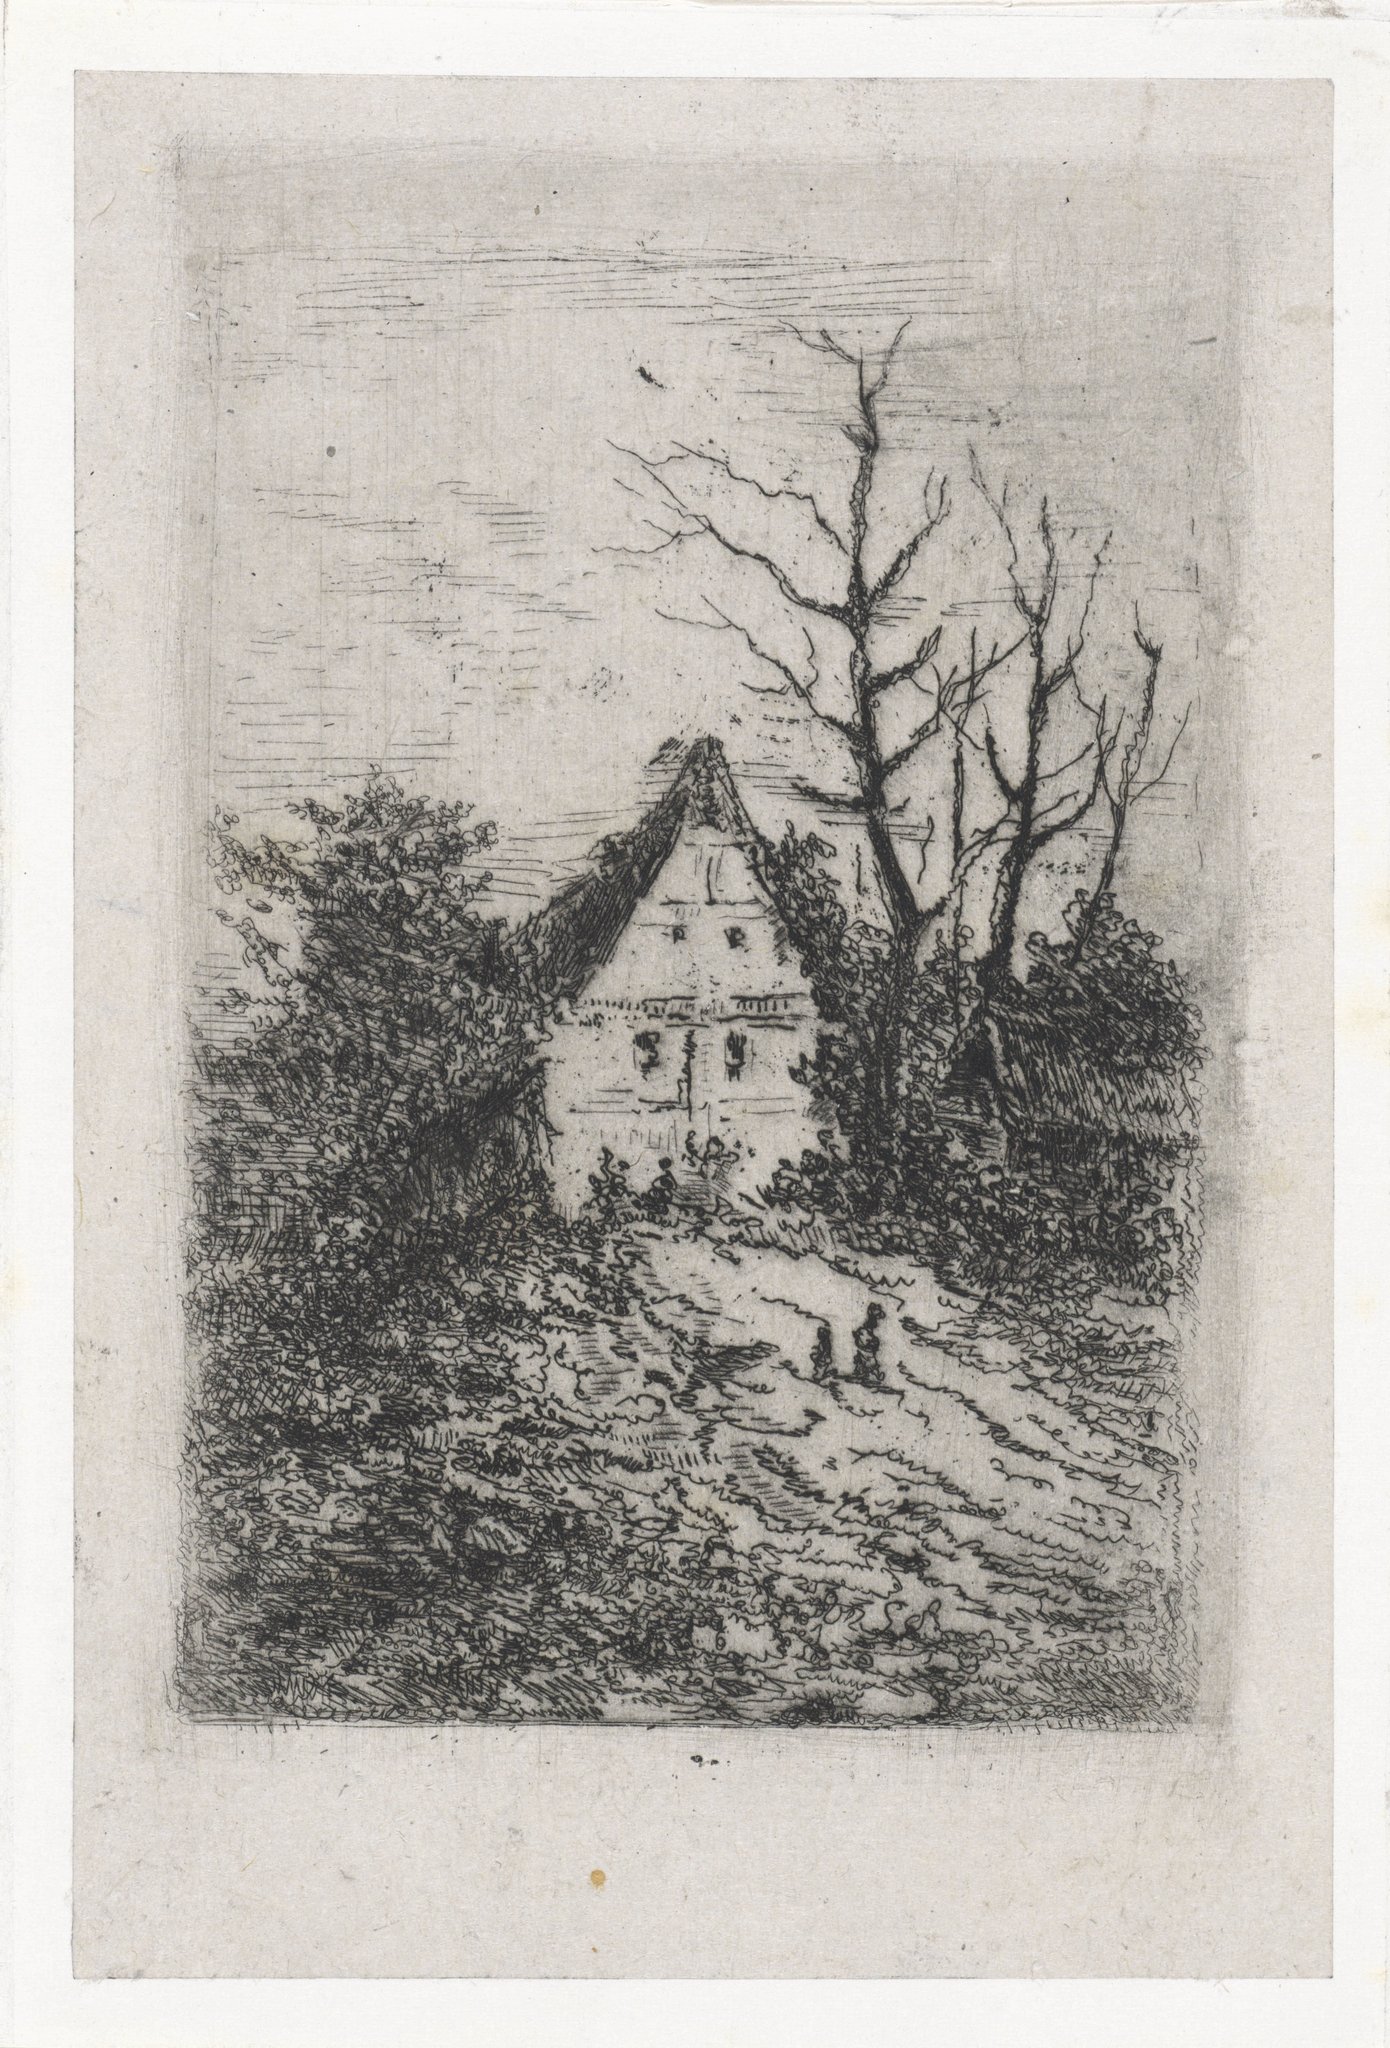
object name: print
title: Huis omgeven door kale bomen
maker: arnoud schaepkens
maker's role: print maker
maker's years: 1816-1904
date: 1831-1904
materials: paper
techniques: drypoint, etching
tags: trees, farm or solitary house in landscape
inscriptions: collector's mark: Lugt 2228